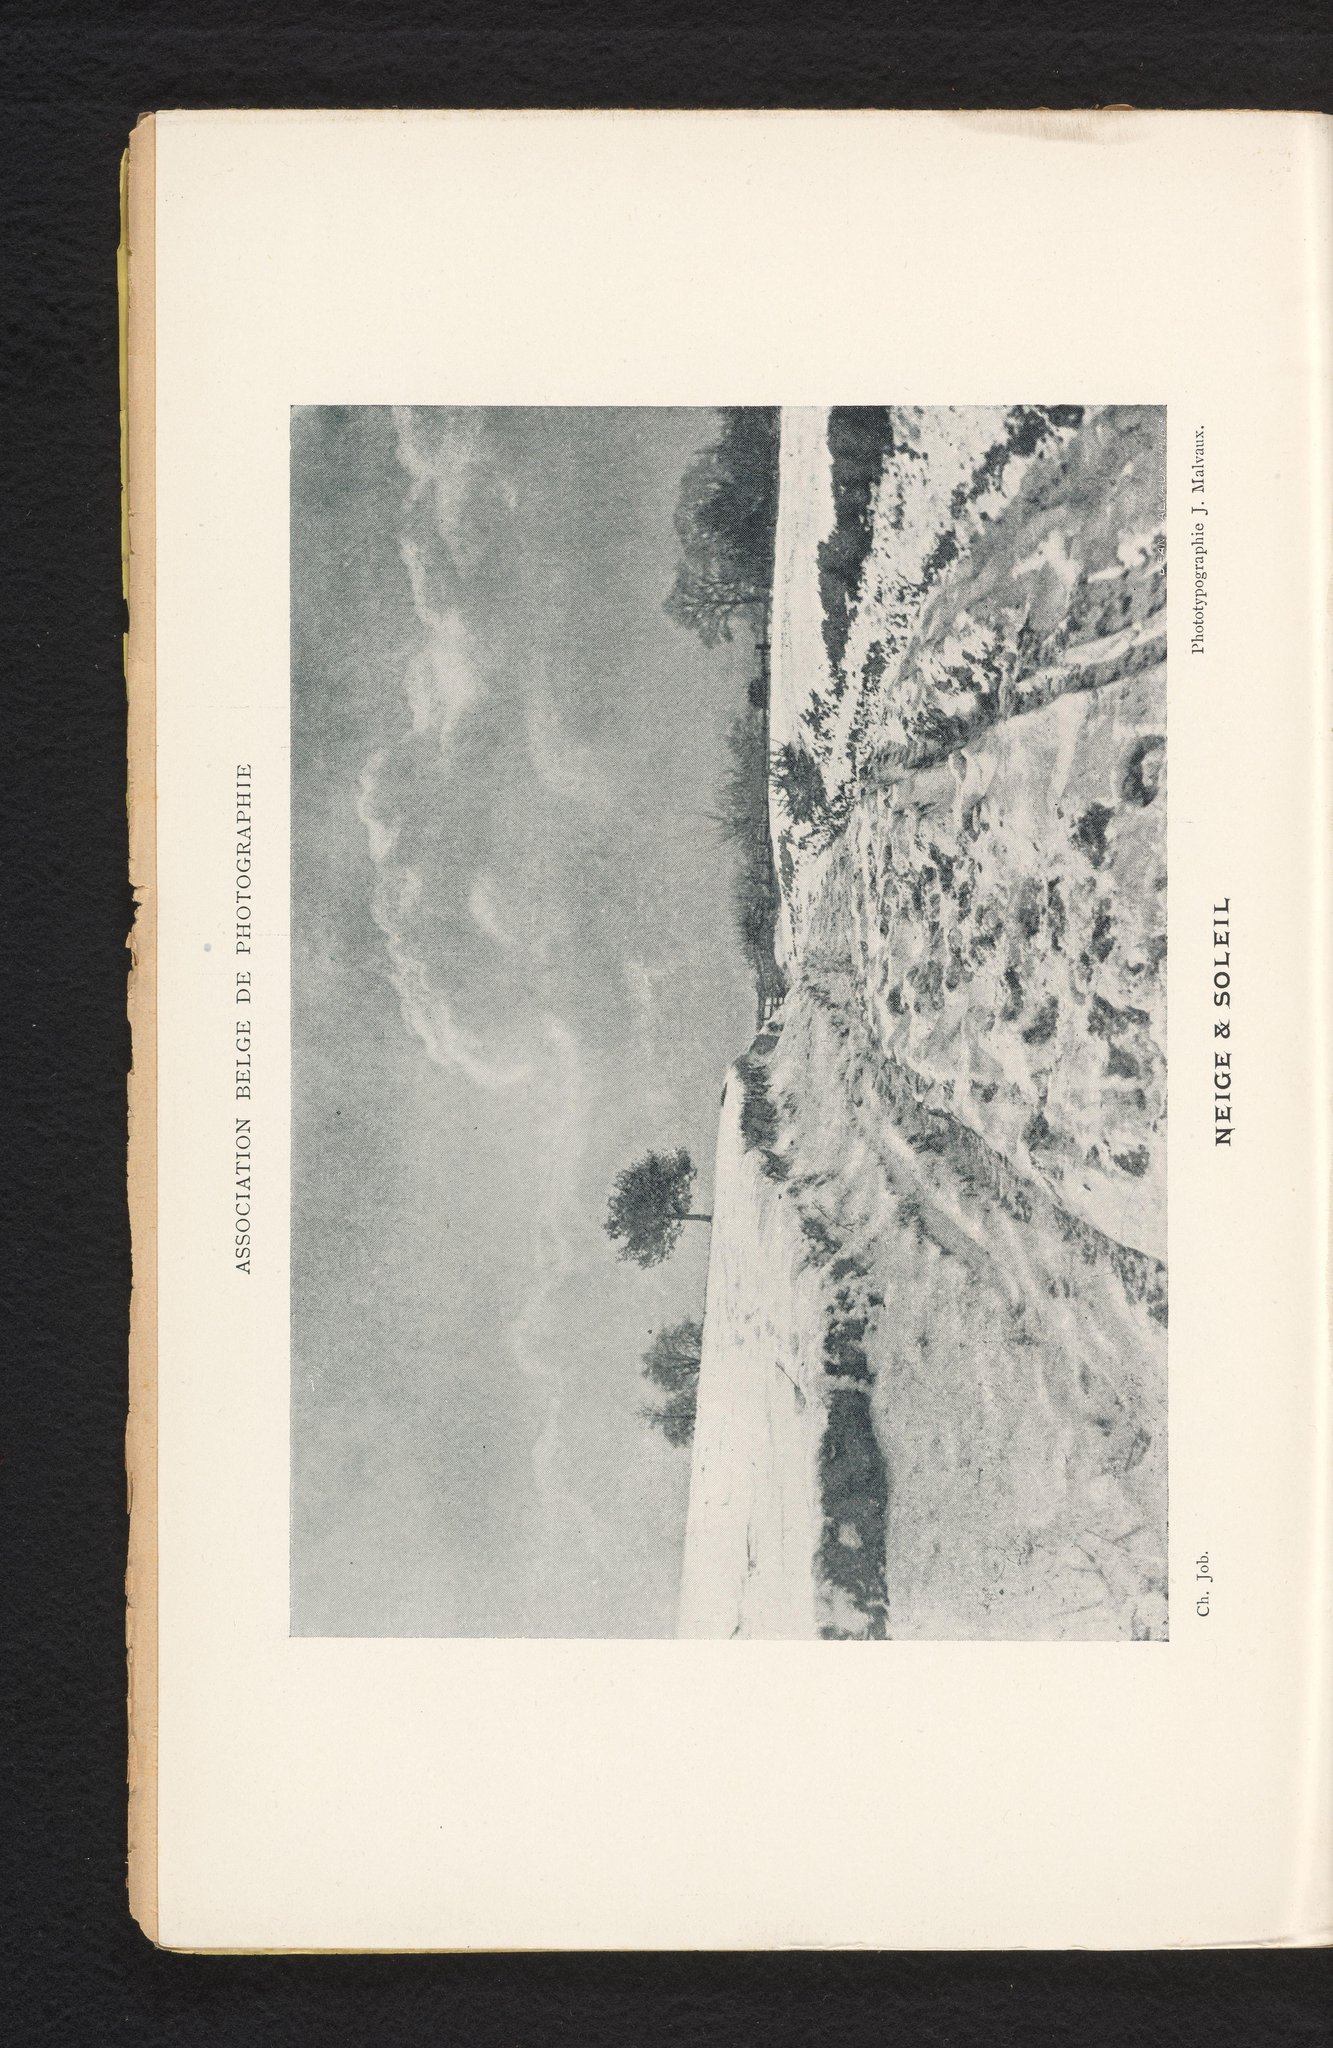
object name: photomechanical print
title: Neige & Soleil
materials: paper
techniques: autotype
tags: winter landscape; landscape symbolizing winter (the four seasons of the year)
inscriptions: inscription: ‘ASSOCIATION BELGE DE PHOTOGRAPHIE’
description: Prent op tweede ongenummerde pagina na pagina XVI.